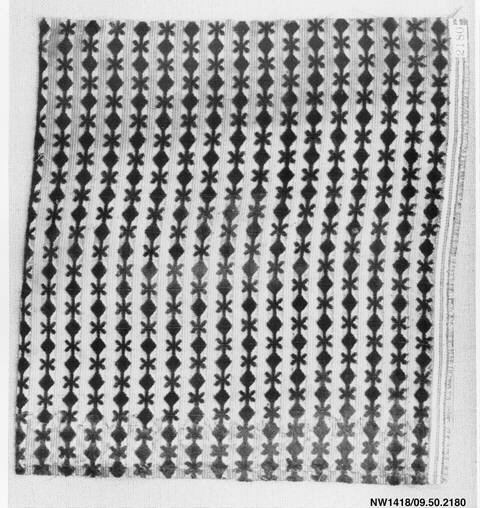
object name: piece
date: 1701-1800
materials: silk